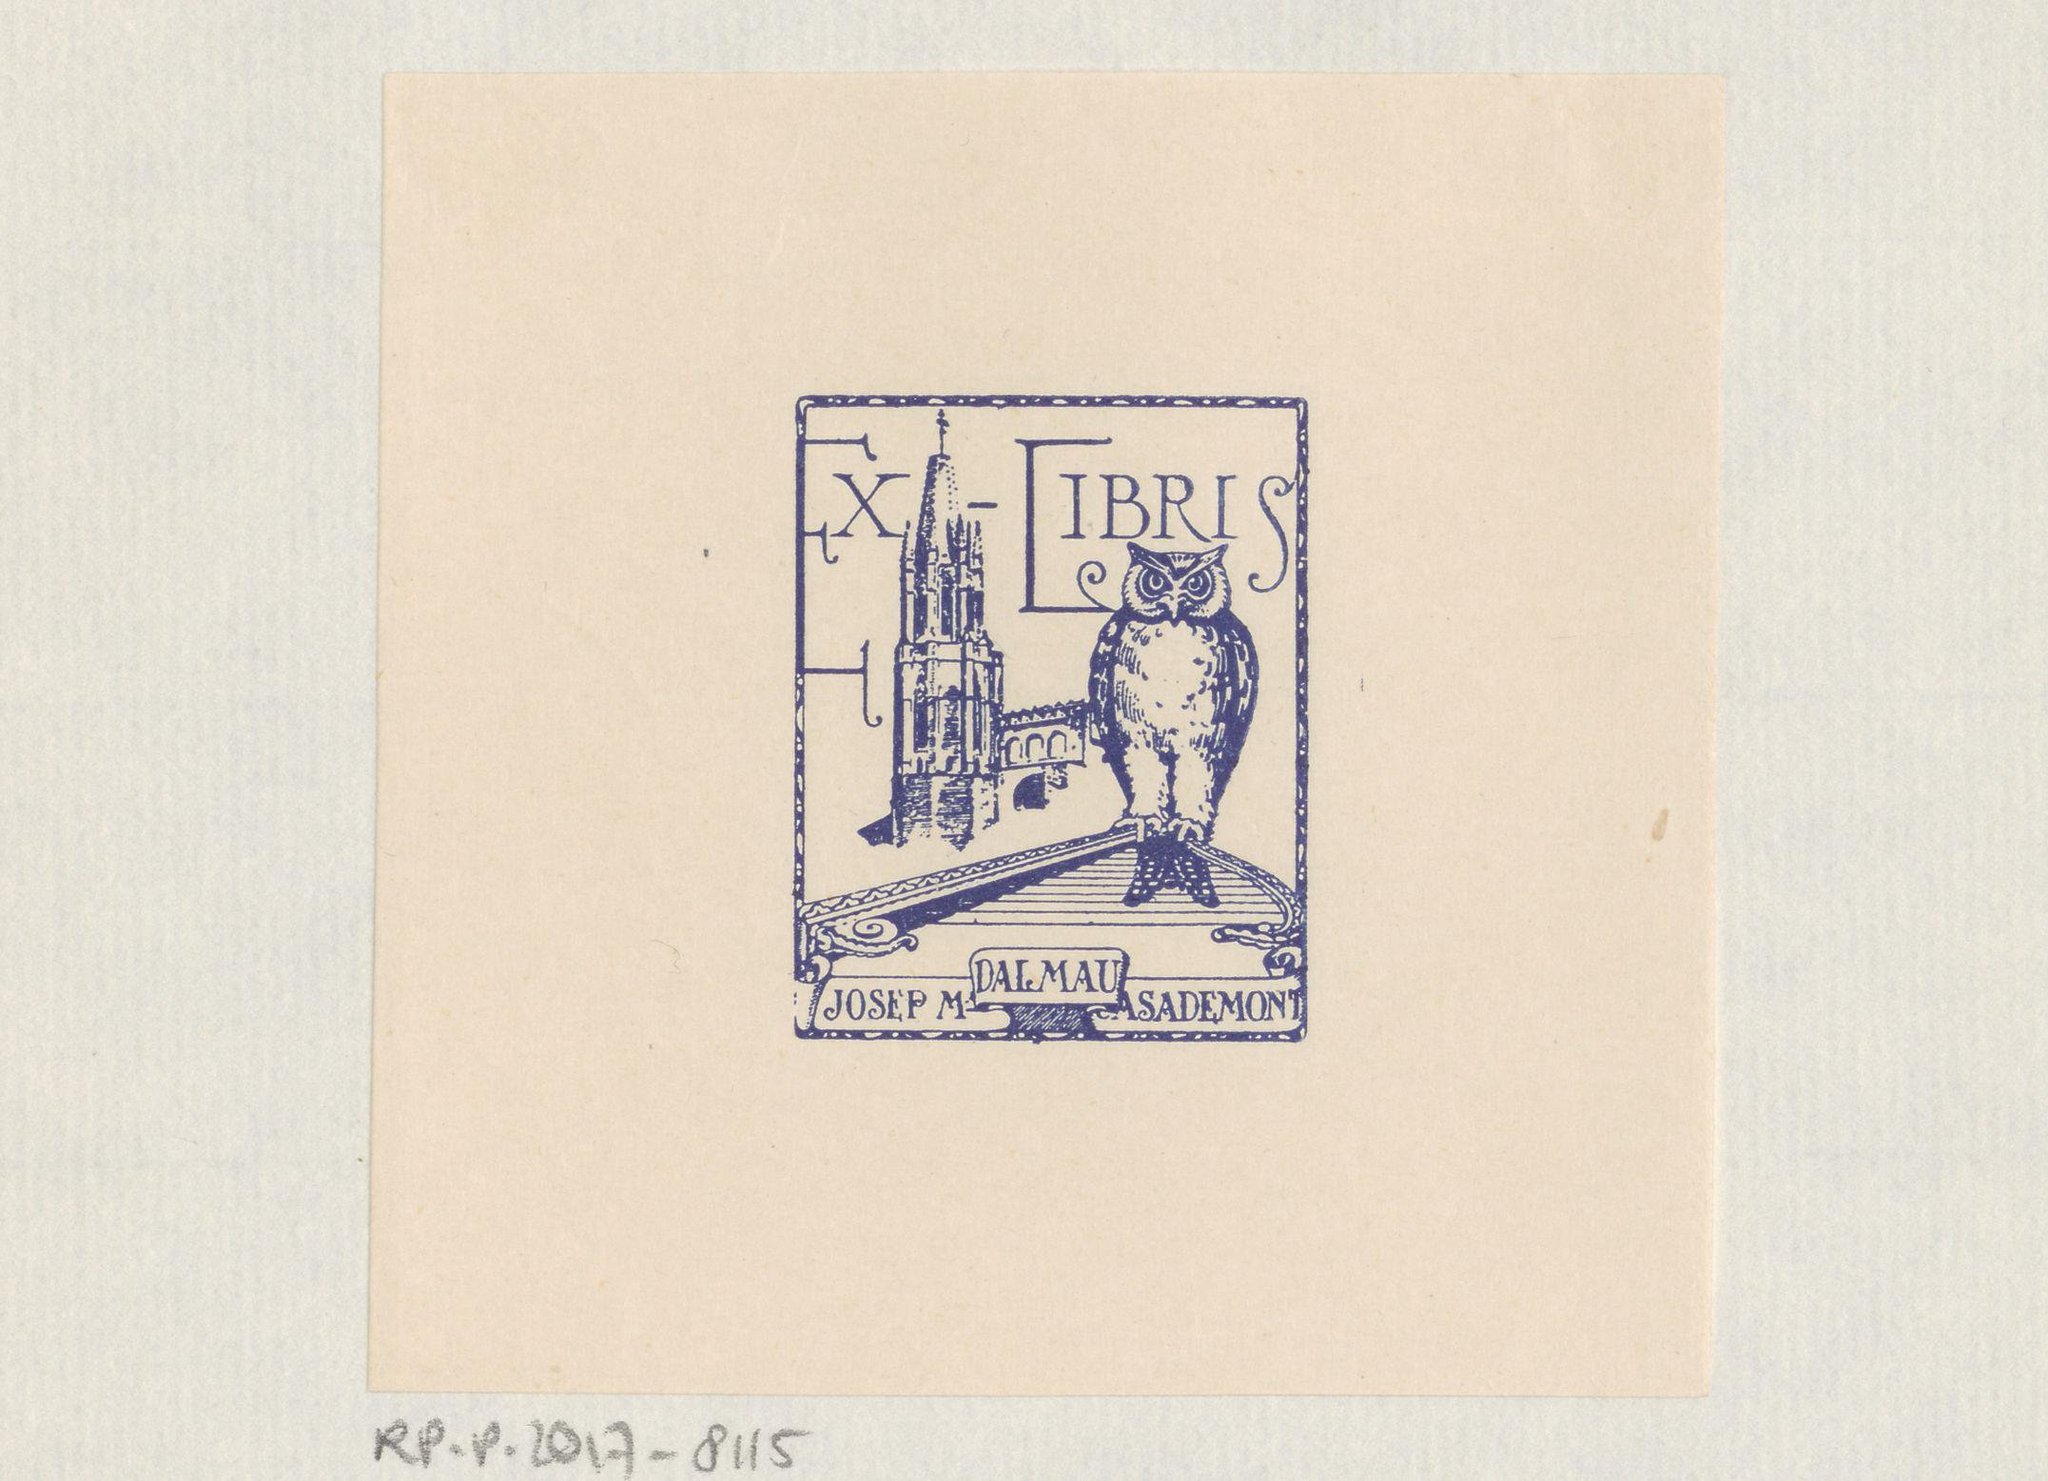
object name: bookplate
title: Ex libris van Josep M. Dalmau Sademont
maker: Anonymous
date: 1898-1959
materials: paper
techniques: printing block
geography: spain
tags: owls